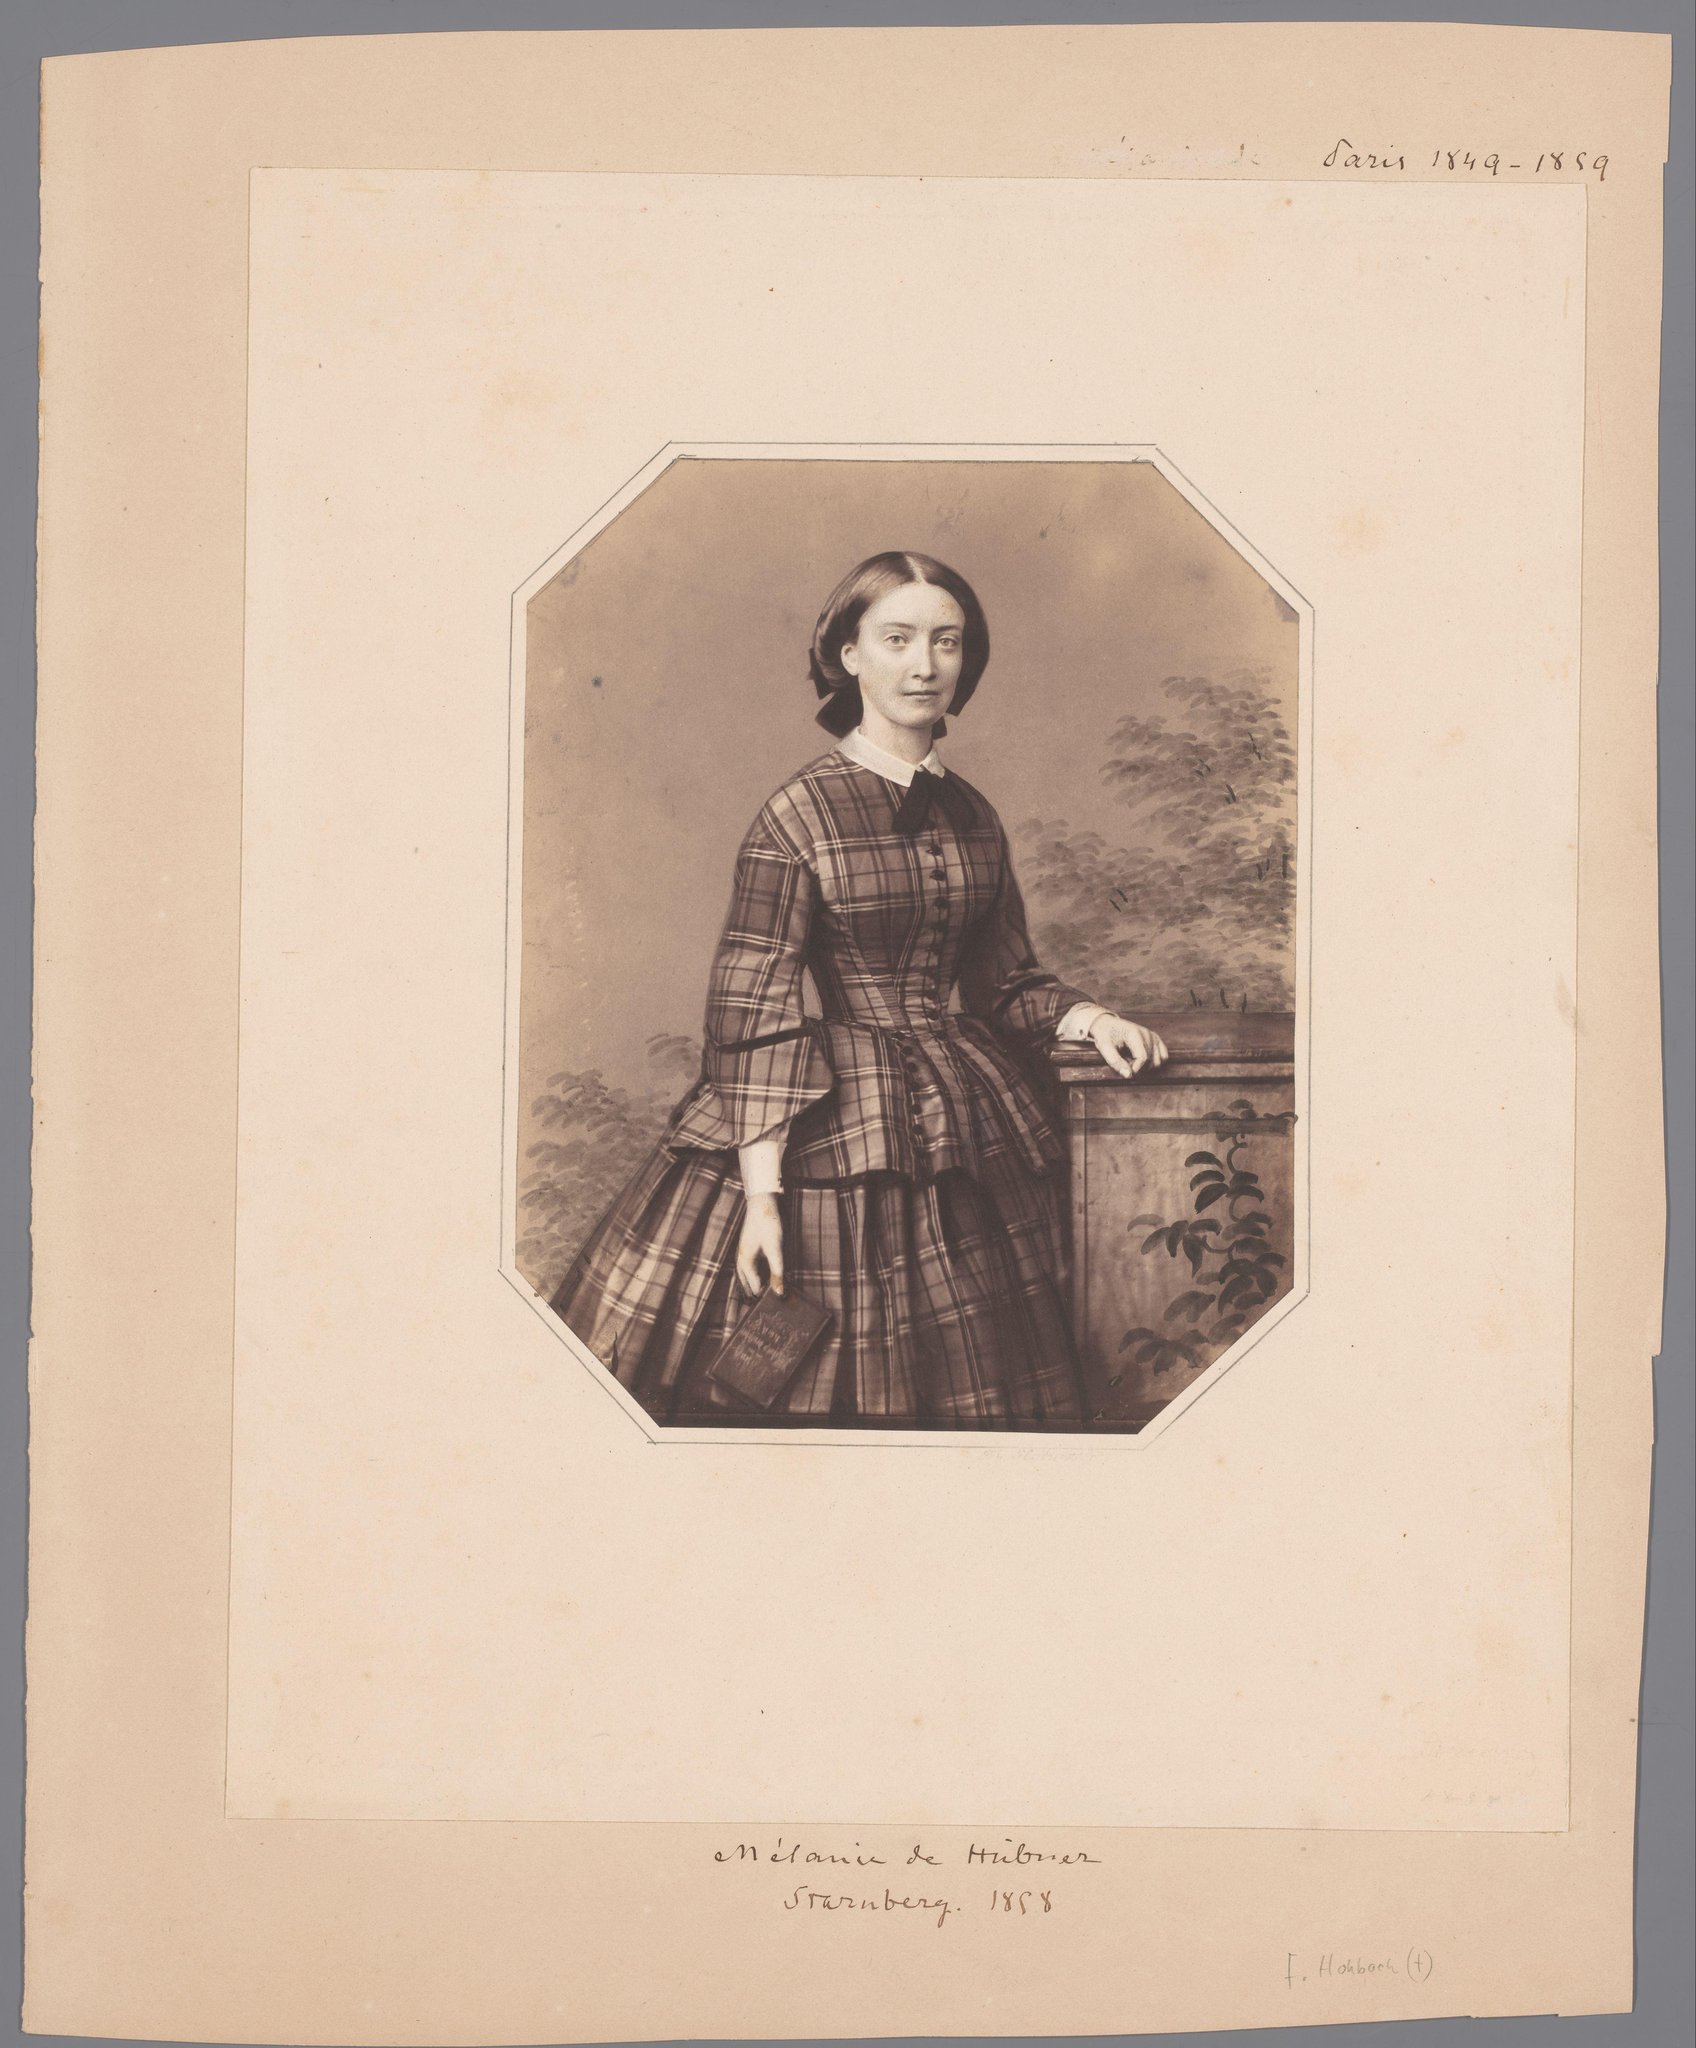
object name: photograph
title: Mélanie de Hübner, Starnberg, Duitsland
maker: franz hohbach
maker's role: fotograaf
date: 1858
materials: paper, photographic support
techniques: salted paper print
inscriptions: caption: ‘Mélanie de Hübner//Starnberg 1858’, inscription: ‘Paris 1849-1859’, caption: ‘F. Hohbach (t)’, caption: ‘Starnberg 1858’, signature: ‘Fr. Hohbach’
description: Mélanie de Hübner draagt een geruite jurk en heeft een boek in haar rechterhand. Starnberg is een stad in Beieren, Duitsland.